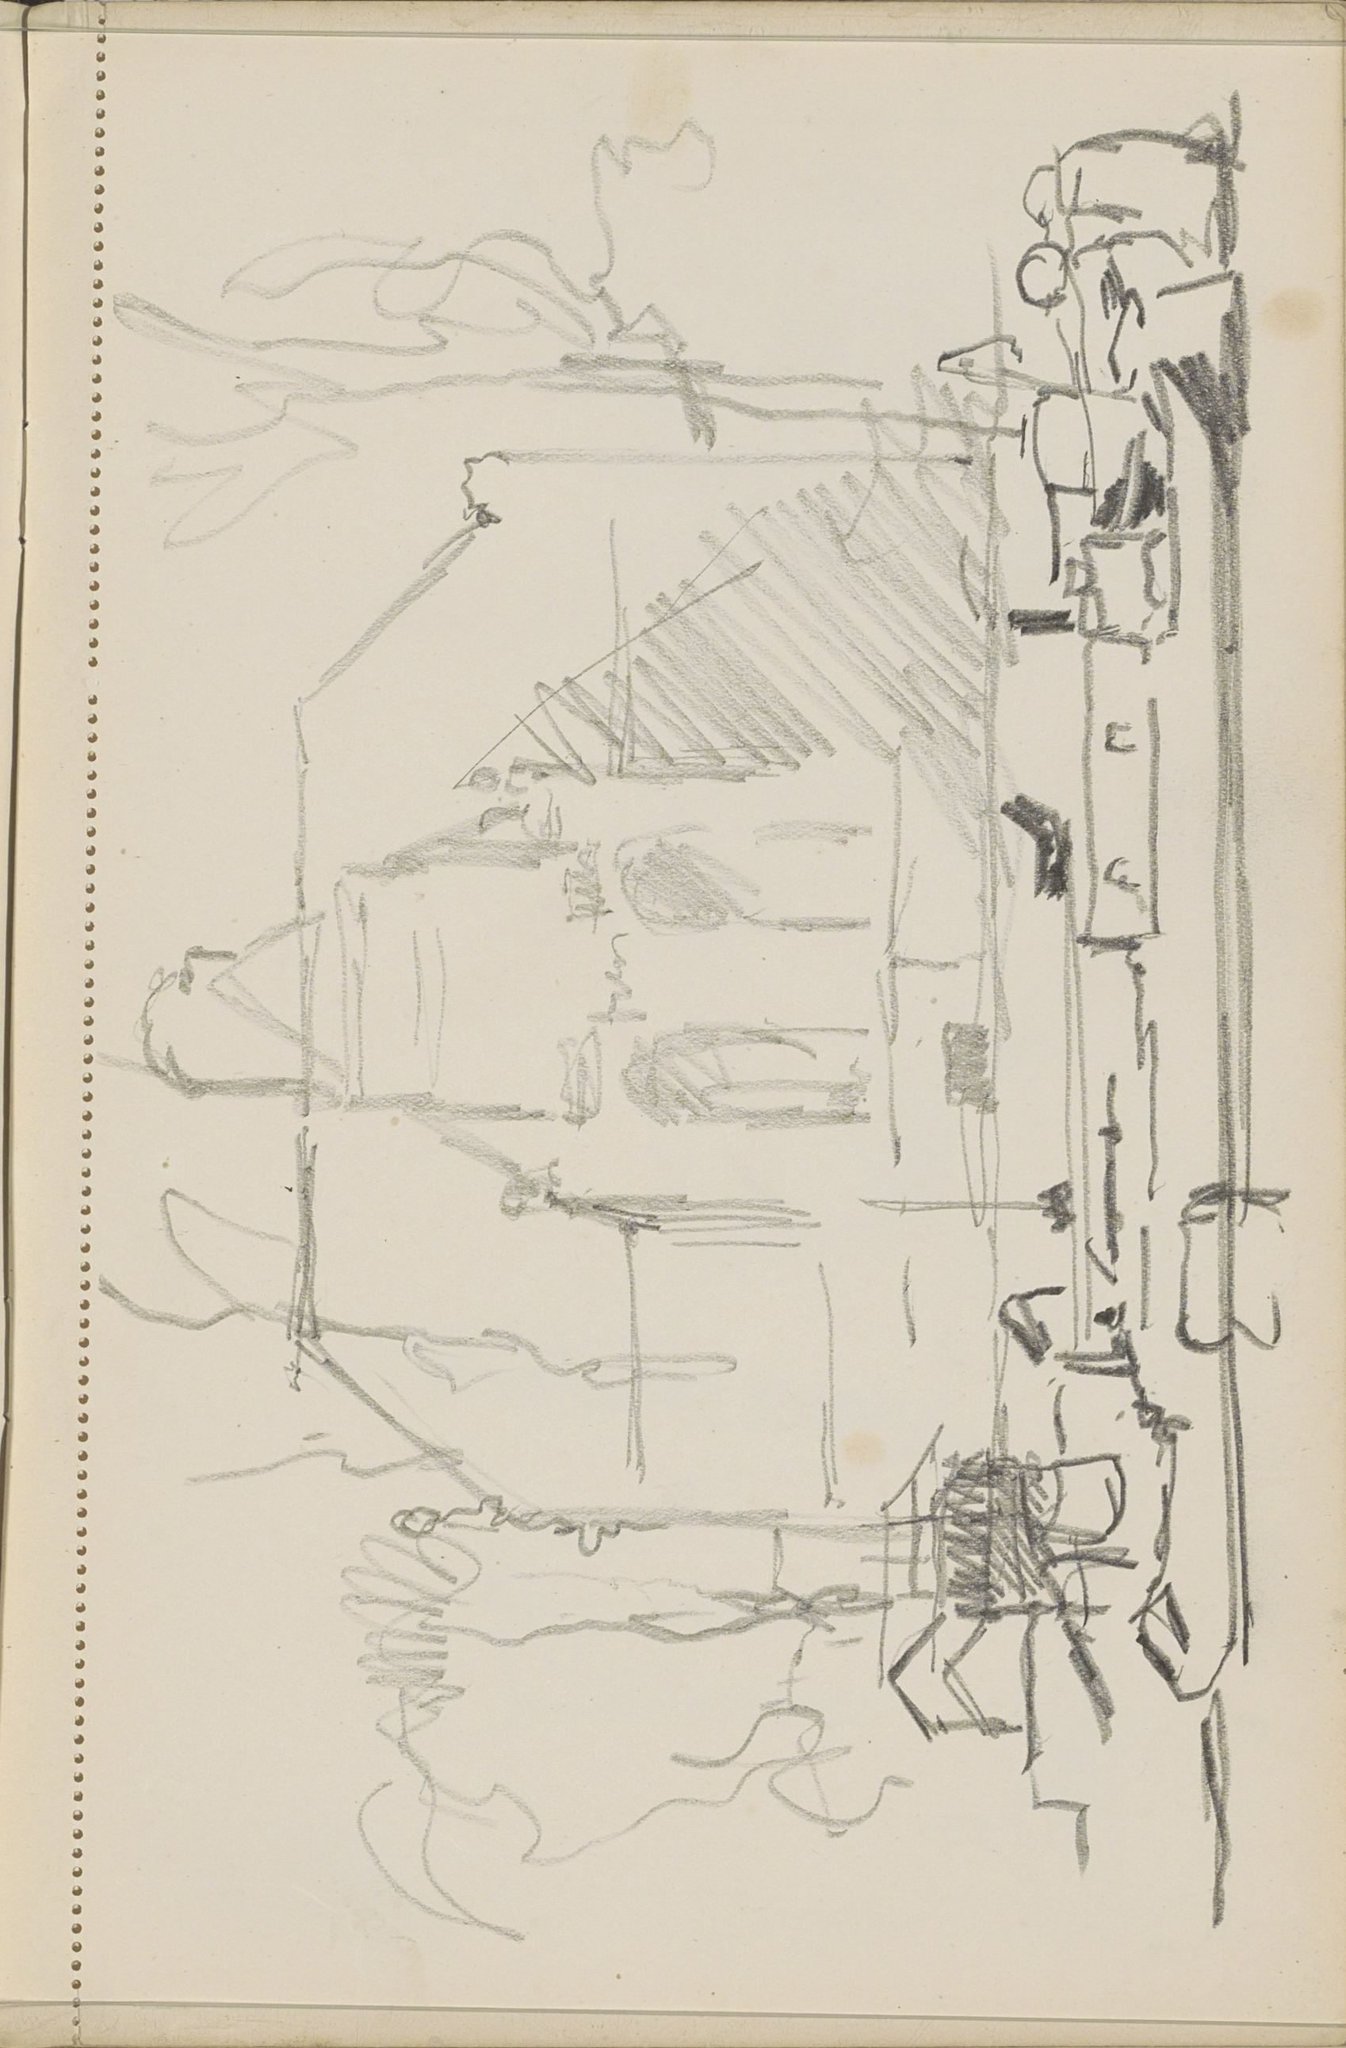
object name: sketchbook leaf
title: Noorderkerk te Amsterdam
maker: cornelis vreedenburgh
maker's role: draughtsman, print maker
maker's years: 1880-1946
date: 1890-1946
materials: paper, pencil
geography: amsterdam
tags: church (exterior), canals, waters (in city)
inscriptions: kleurnotitie, handgeschreven in potlood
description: Op de voorgrond ligt een boot op de Prinsengracht. Blad 41 recto uit een schetsboek met 59 bladen.